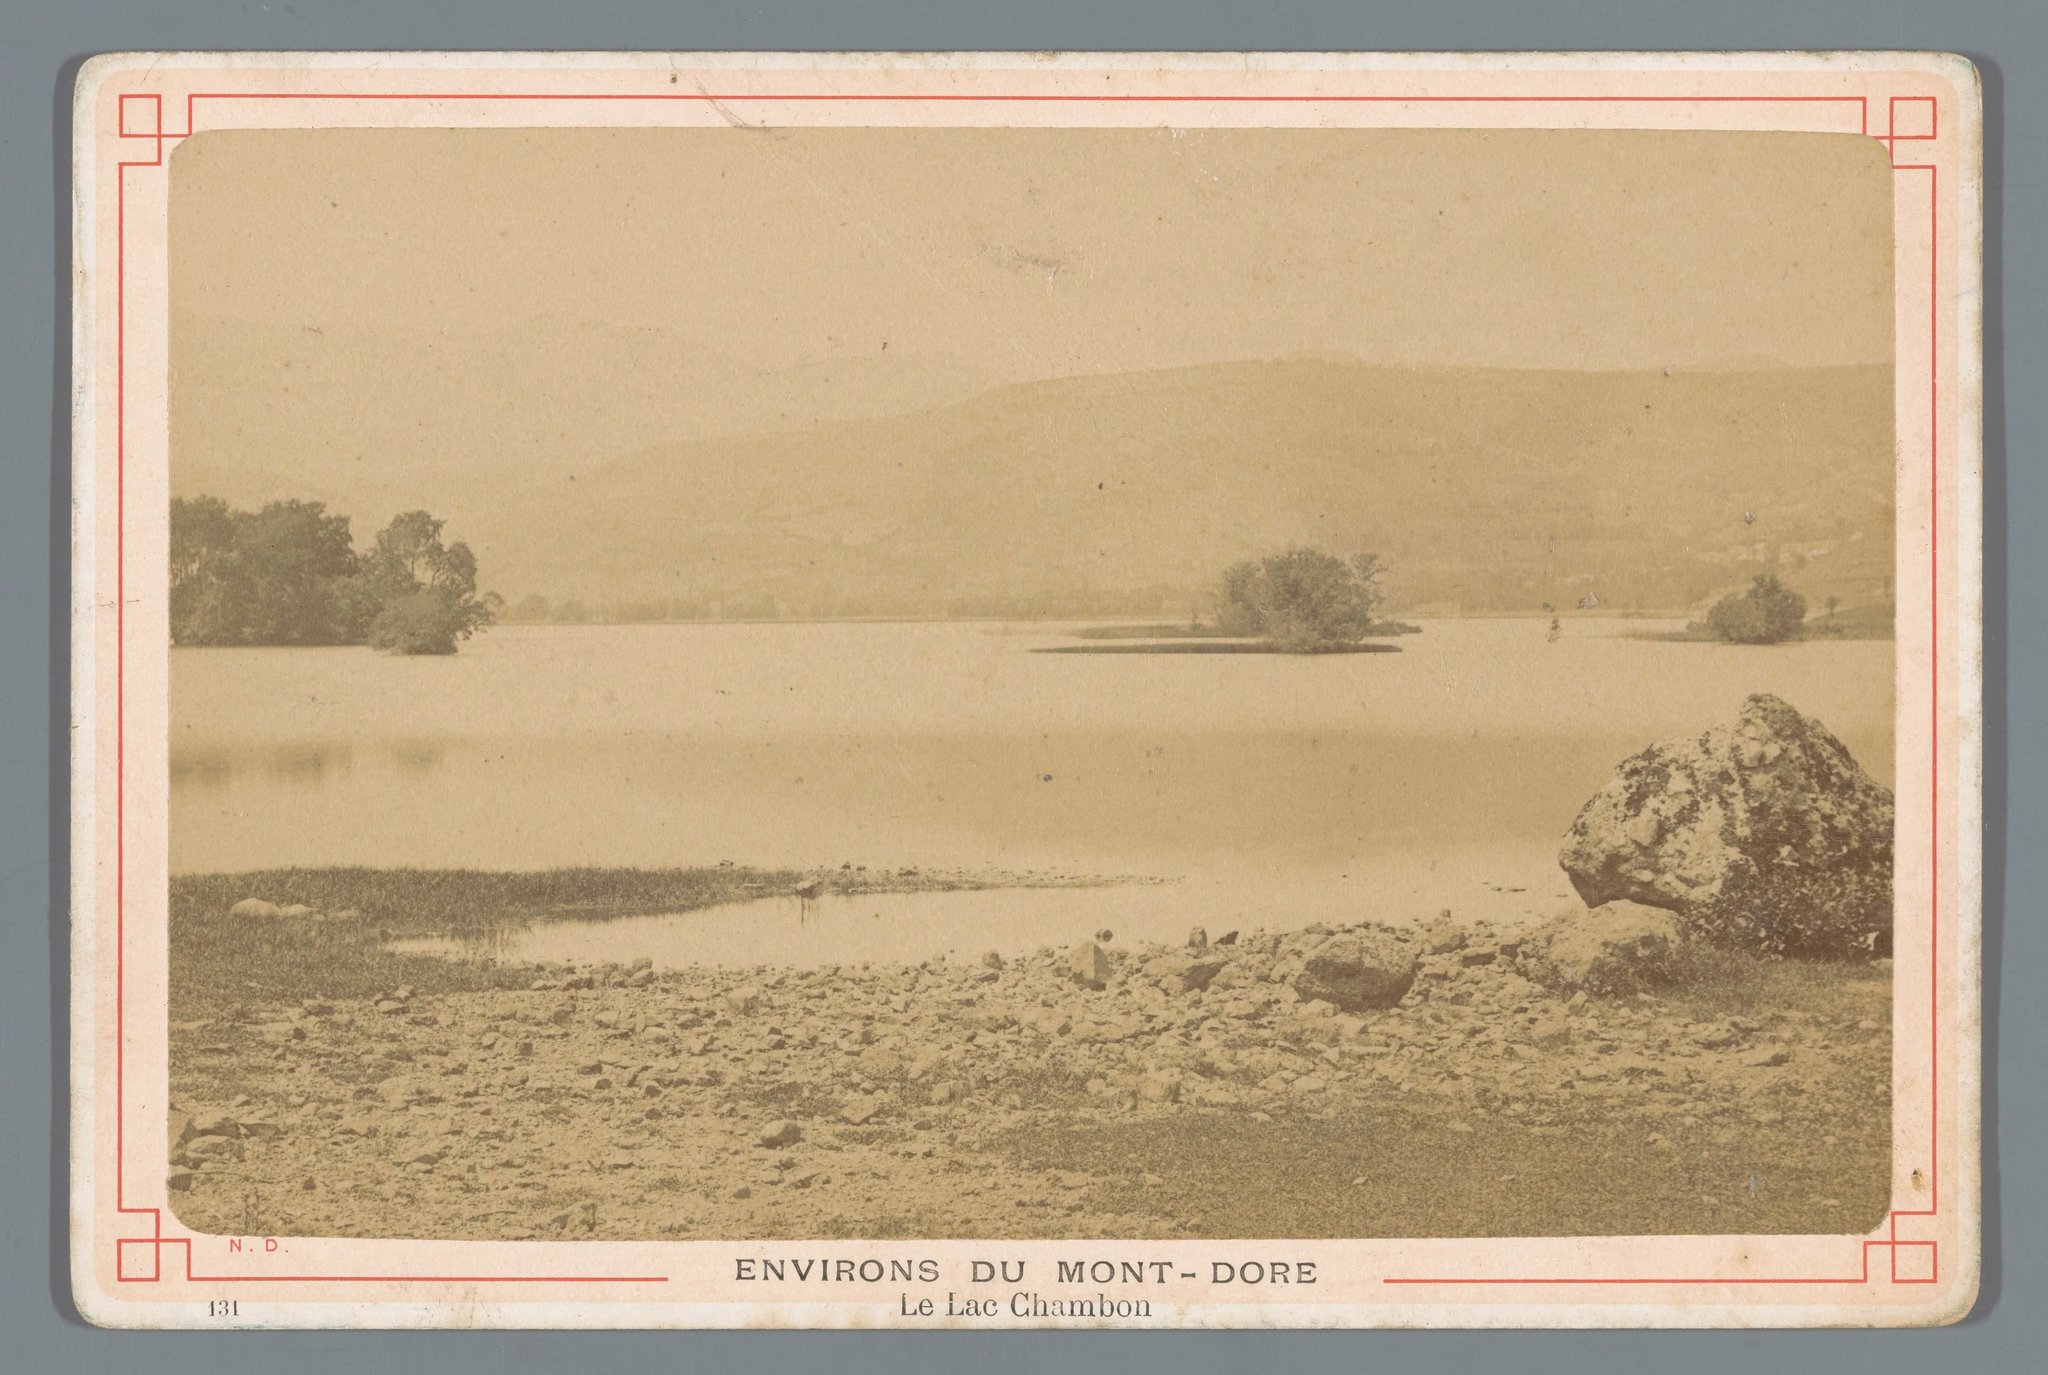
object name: photograph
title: Le Lac Chambon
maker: étienne neurdein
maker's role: publisher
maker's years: 1832-1918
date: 1870-1900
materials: cardboard, photographic support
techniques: albumen print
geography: mont-dore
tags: lake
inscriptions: number: ‘131’, initials: ‘N.D.’, retailer's mark: ‘PAPETERIE PAITRE/ 29. - Rue Saint-Hérem. - 29/ CLERMONT-FERRAND’, inscription: ‘ENVIRONS DU MONT-DORE’